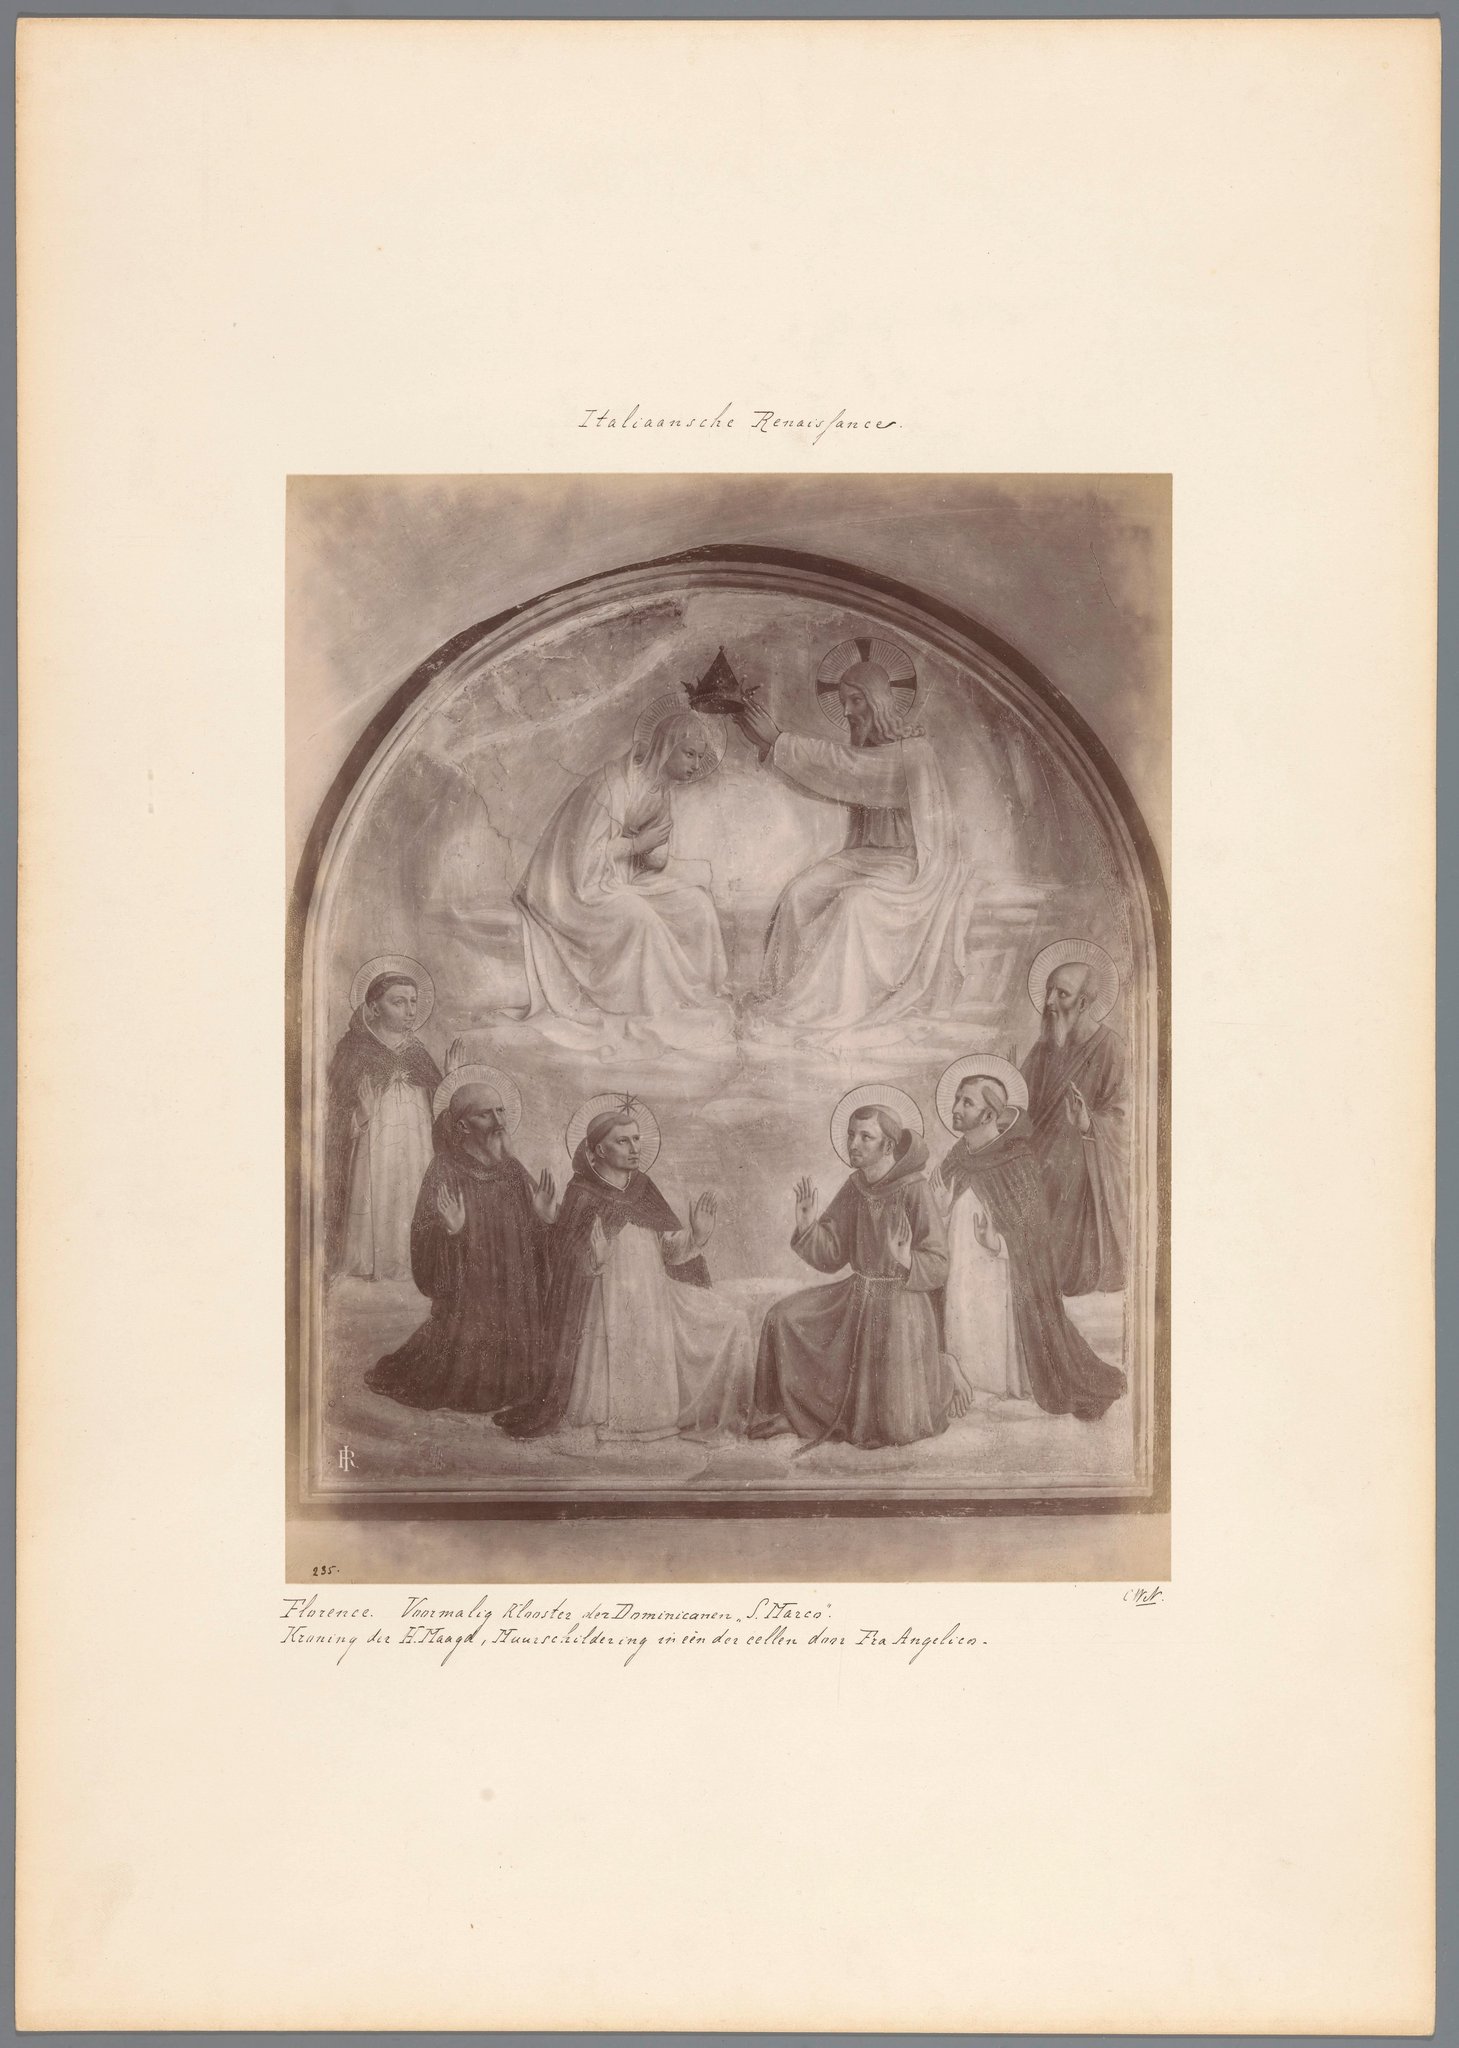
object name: reproduction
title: Fotoreproductie van een fresco in het voormalig San Marco klooster te Florence door Fra Angelico, voorstellend de kroning van Maria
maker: Anonymous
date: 1875-1900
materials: cardboard, photographic support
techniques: albumen print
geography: florence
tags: coronation of mary by christ, painting (including book-illumination, miniature-painting) (+ plaster ~ arts)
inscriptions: inscription: ‘IR’, collector's mark: ‘INSTITUUT VOOR KUNST-NIJVERHEIDSONDERWIJS GABRIËL METSUSTRAAT No. 16 AMSTERDAM’, collector's mark: ‘KUNSTNIJVERHEIDSCHOOL QUELLINUS AMSTERDAM FRANS HALSSTRAAT 14.’, inscription: ‘CWN.’, inscription: ‘Italiaansche Renaissance.’, number: ‘235.’